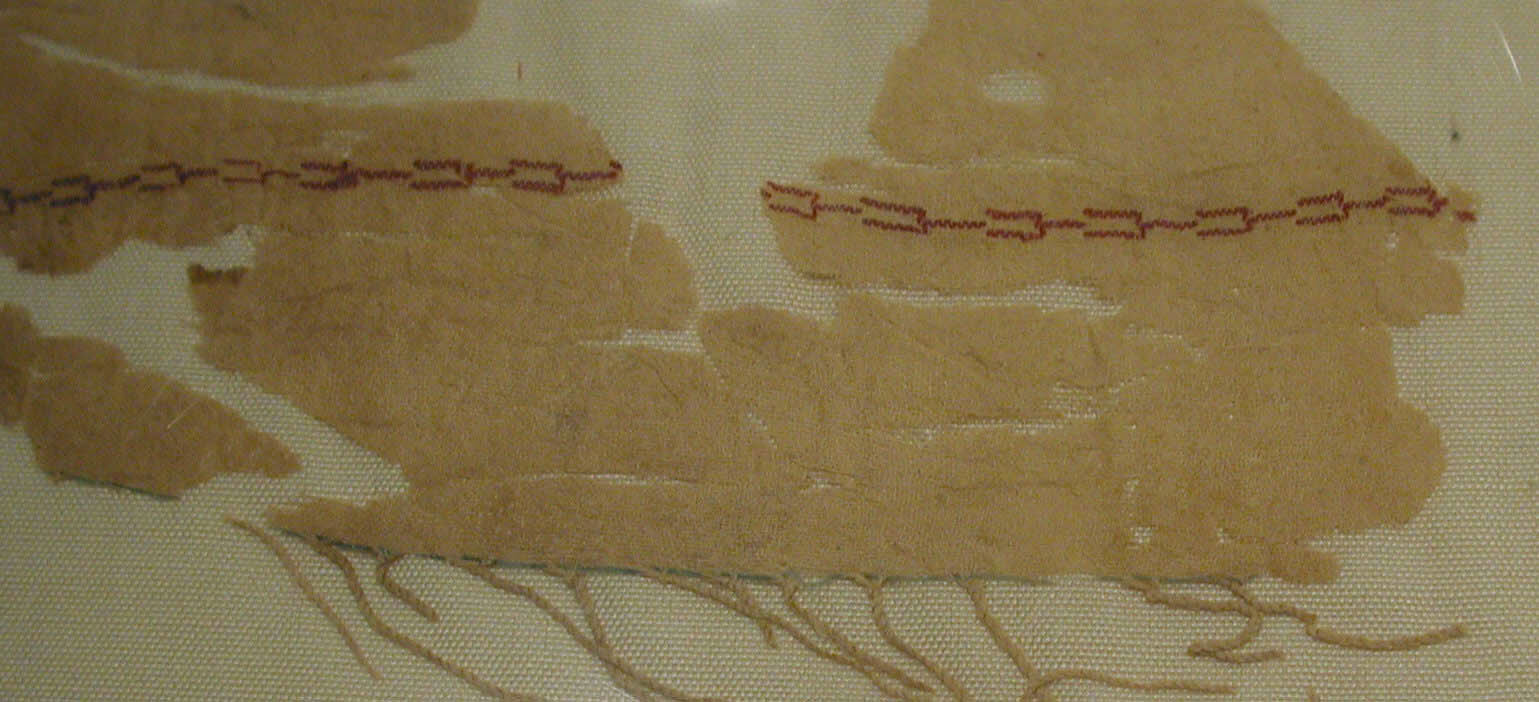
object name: textile fragment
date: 1001-1200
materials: linen, silk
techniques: embroidery, weave